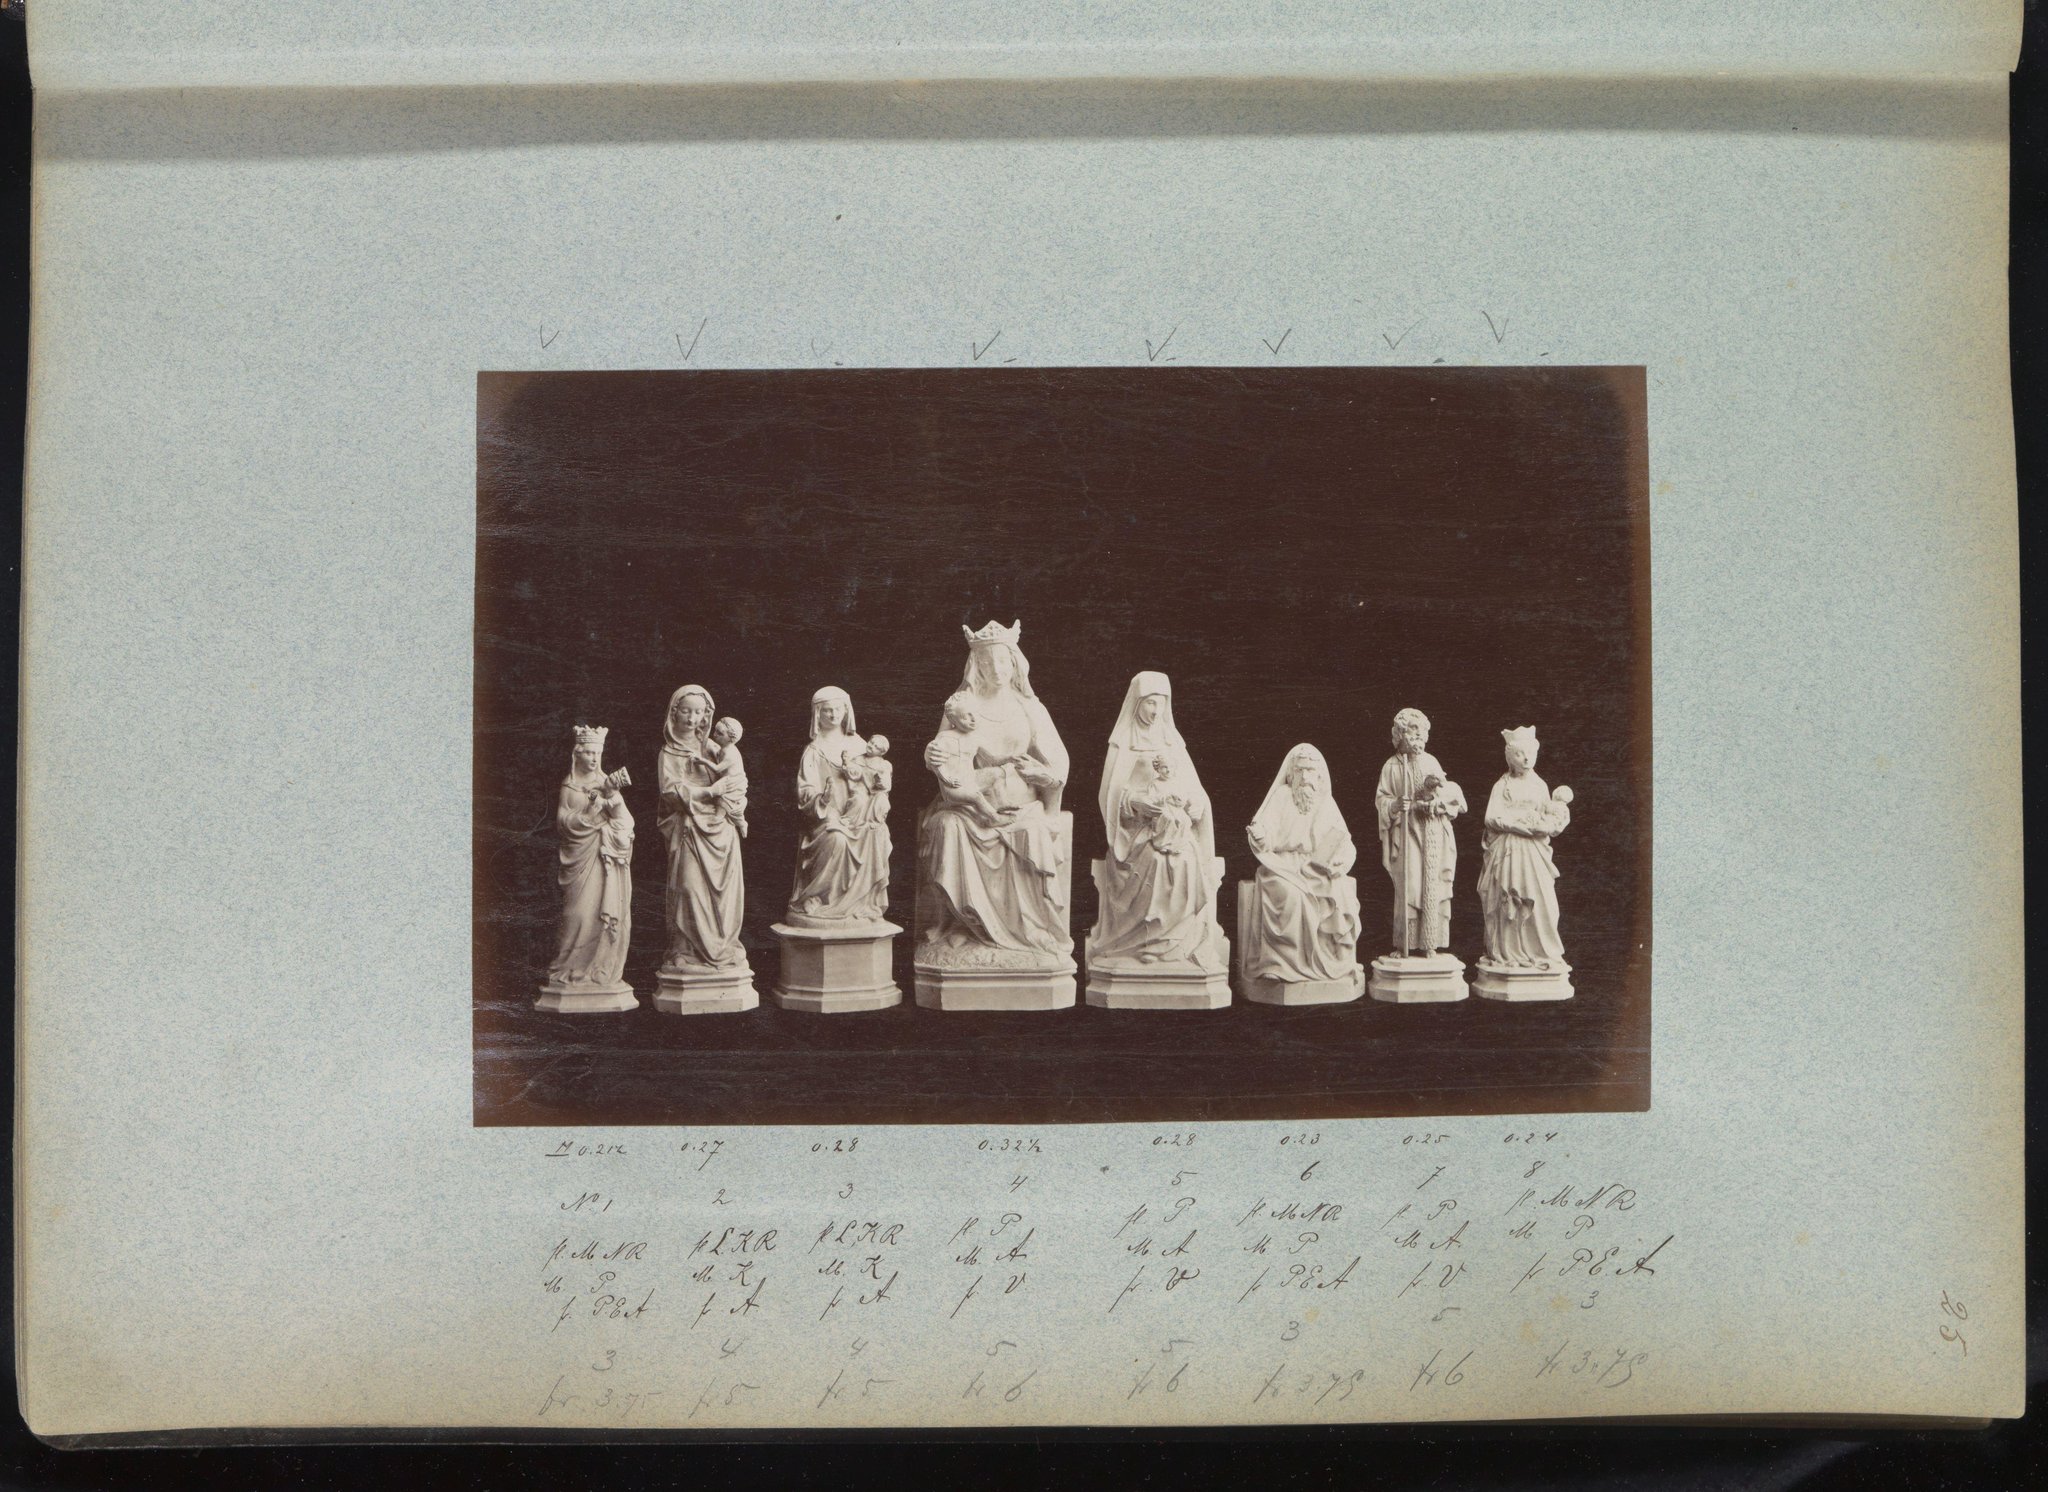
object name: album leaf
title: Acht gipsen afgietsels van religieuze sculpturen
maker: Anonymous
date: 1875-1900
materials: paper, photographic support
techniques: albumen print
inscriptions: annotation: ‘M 0.21 1/2 M 0.27 M 0.28 M 0.31 1/2 M 0.28 M 0.23 M 0.25 M 0.24’, annotation